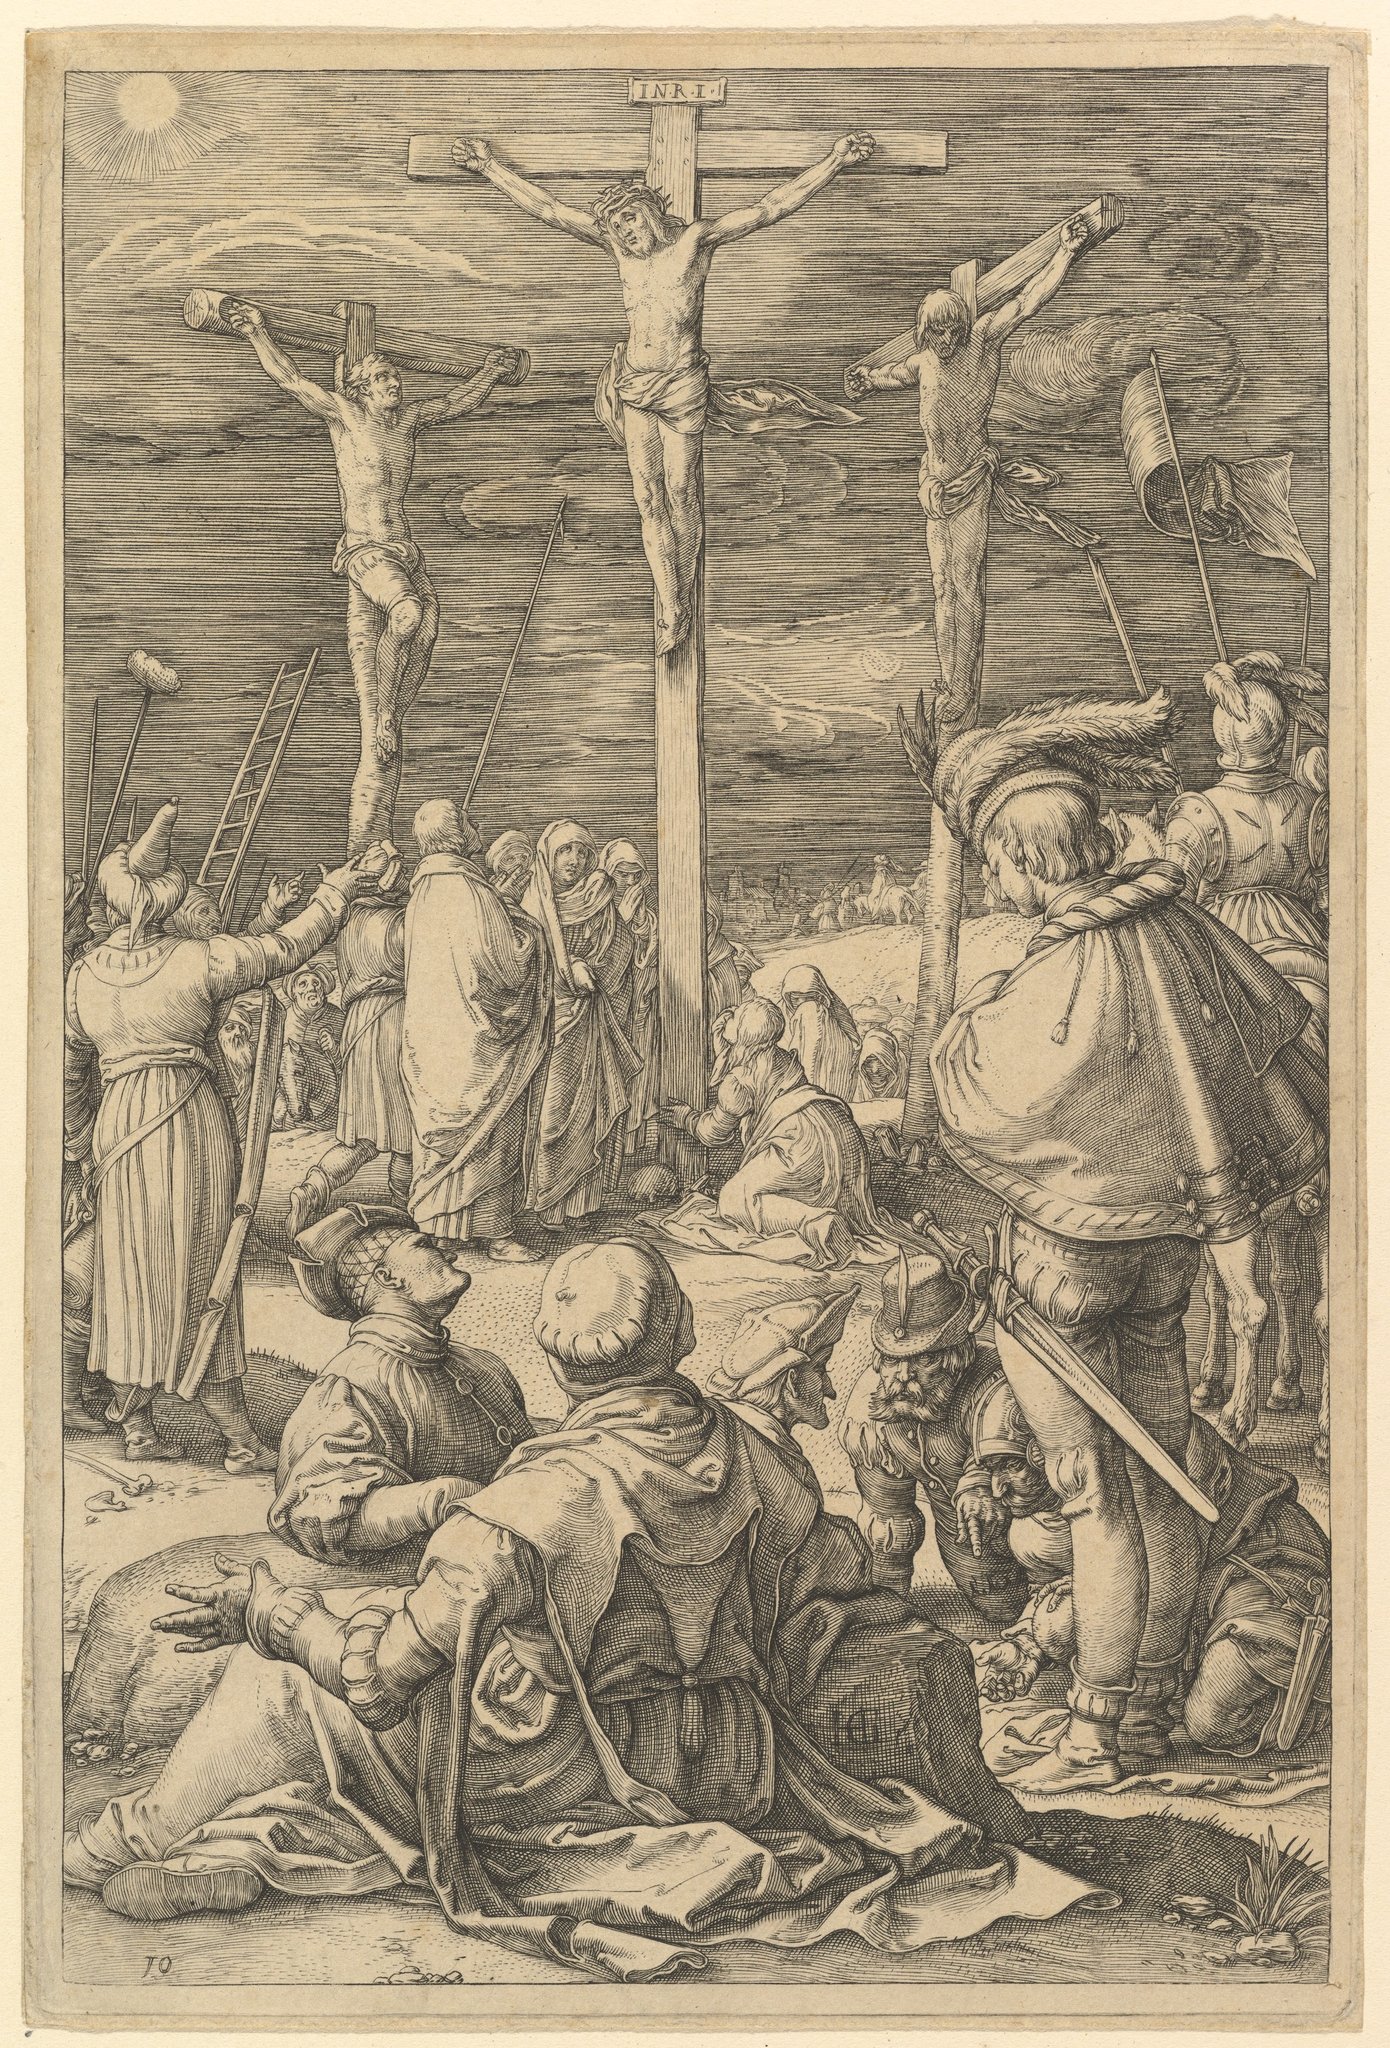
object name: print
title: Christ on the Cross, from "The Passion of Christ"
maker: hendrick goltzius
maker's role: artist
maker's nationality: netherlandish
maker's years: 1558-1617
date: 1596-1598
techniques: engraving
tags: crucifixion